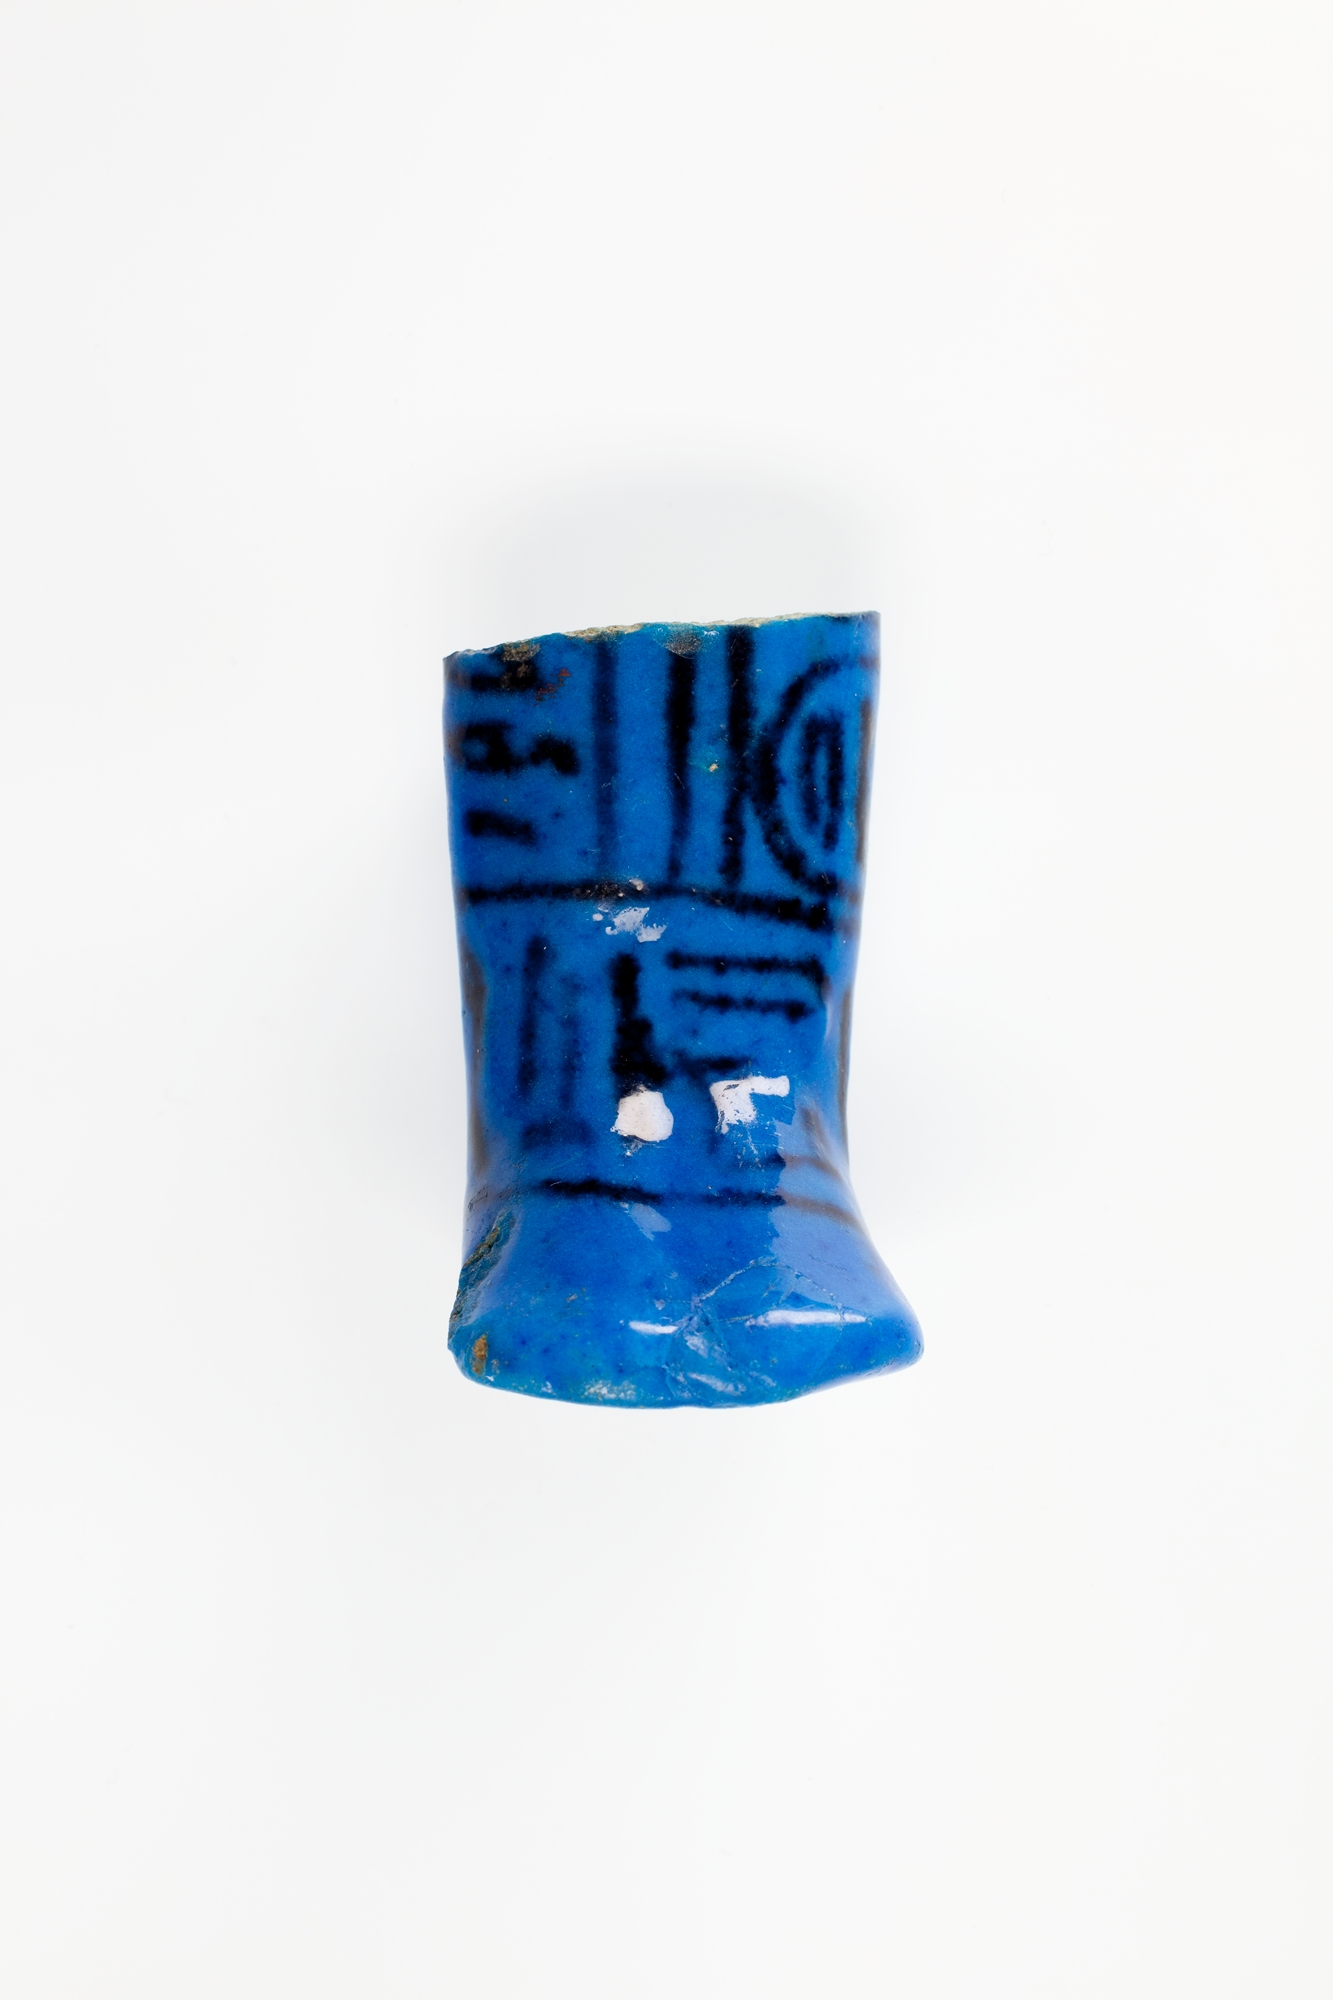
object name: shabti base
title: Shabti fragment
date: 1295-1070 BCE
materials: faience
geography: egypt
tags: hieroglyphs